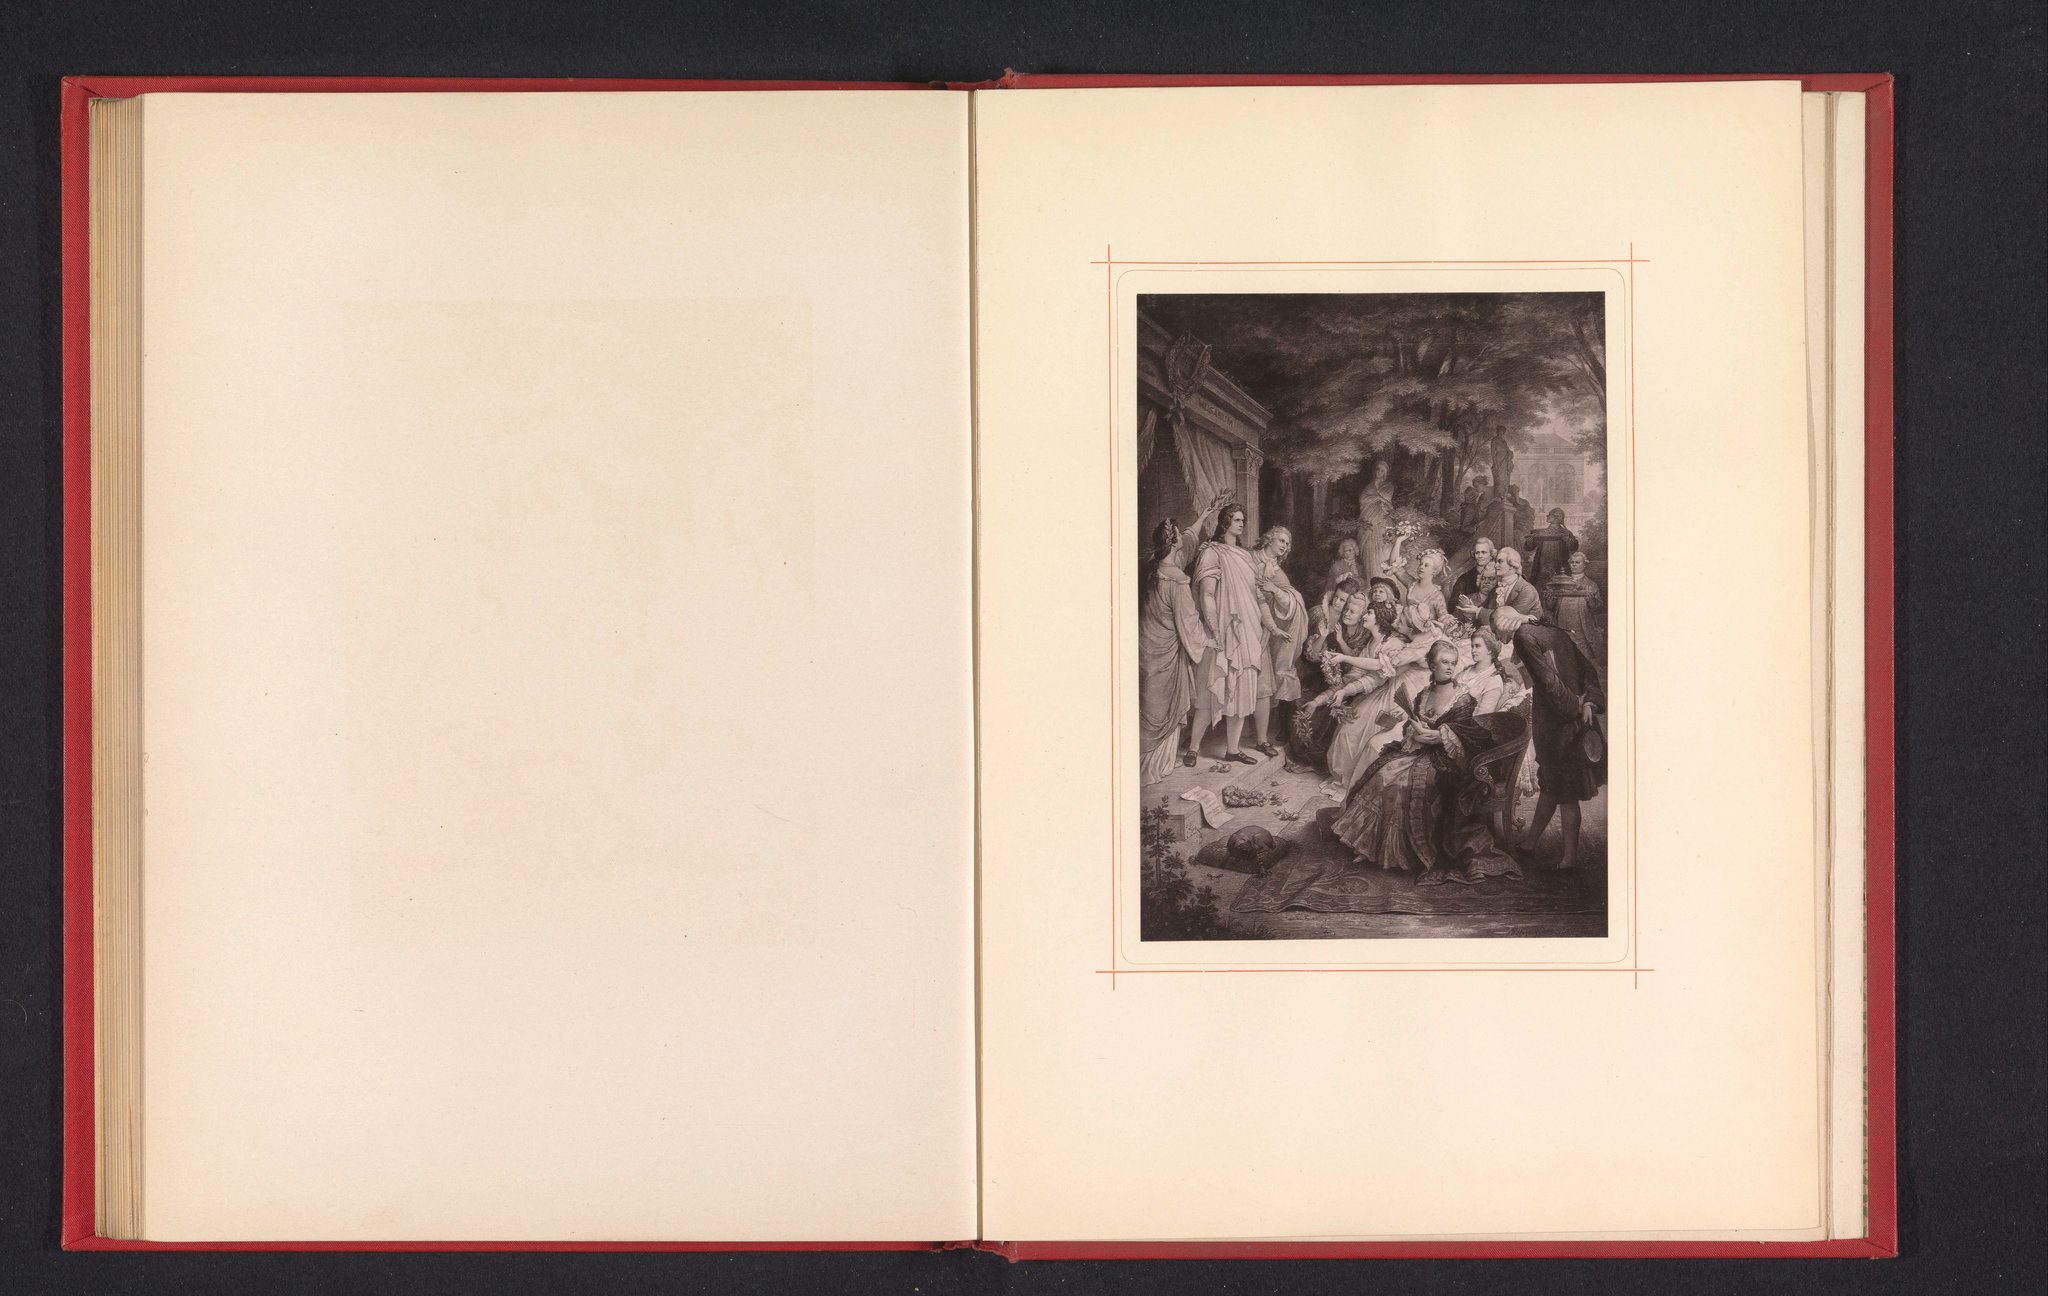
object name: page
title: Fotoreproductie van een tekening, voorstellende Johann Wolfgang von Goethe wordt gelauwerd door een gezelschap te Weimar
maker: Anonymous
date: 1875-1880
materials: paper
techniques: photograph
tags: draughtsman, johann wolfgang von goethe, honouring the artist with laurel wreath, portrait of a writer